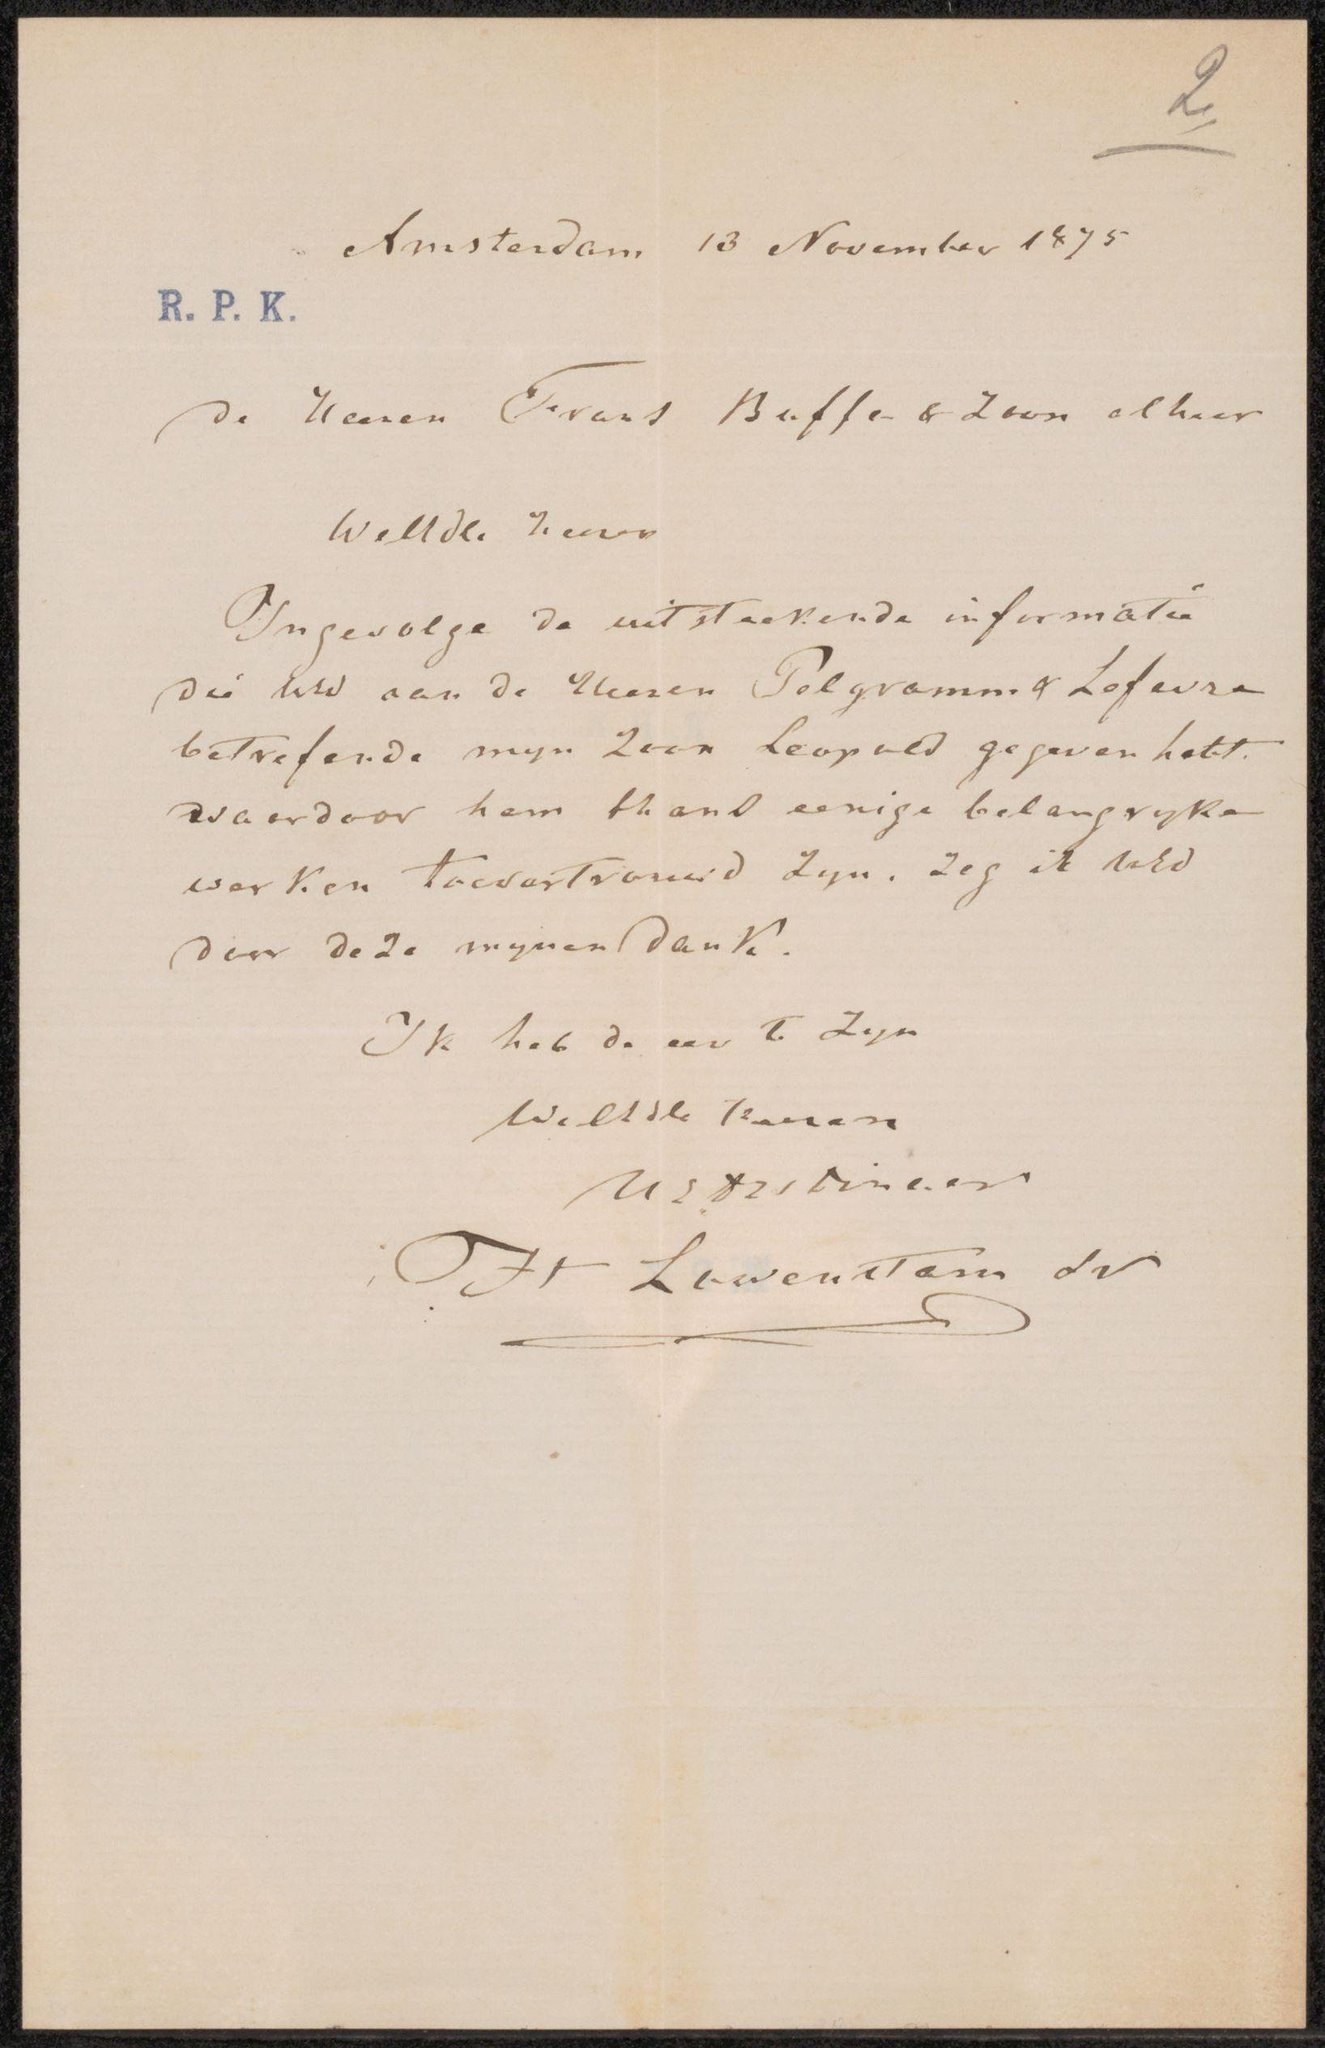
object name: letter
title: Brief aan Frans Buffa en Zonen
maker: Anonymous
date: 1875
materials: ink, paper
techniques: pen, writing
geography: amsterdam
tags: print maker, leopold löwenstam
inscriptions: collector's mark: Lugt 2233